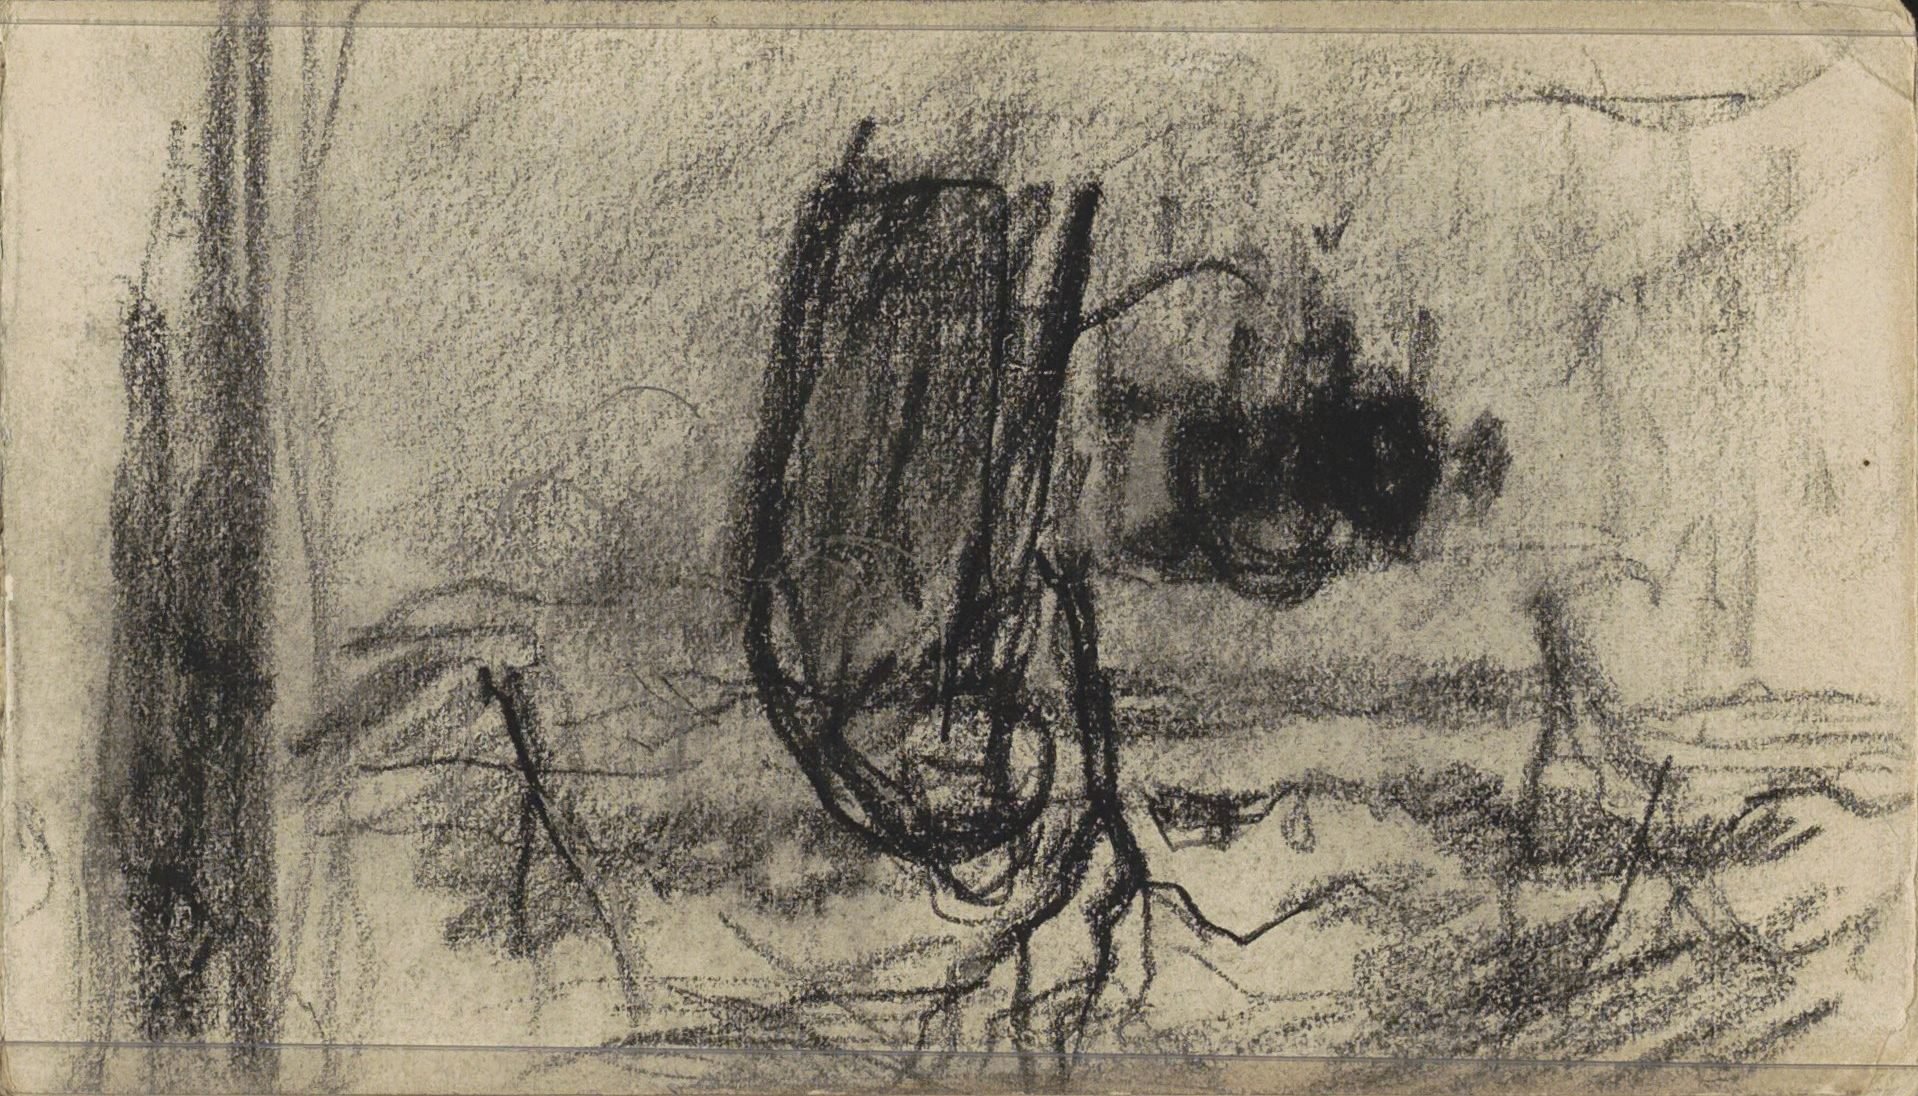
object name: sketchbook leaf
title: Landschap met een figuur bij een dier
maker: anton mauve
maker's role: draughtsman, painter, print maker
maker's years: 1838-1888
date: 1876-1879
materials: chalk, paper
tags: landscapes (+ landscape with figures, staffage)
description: Blad 3 recto uit een schetsboek met 33 bladen.